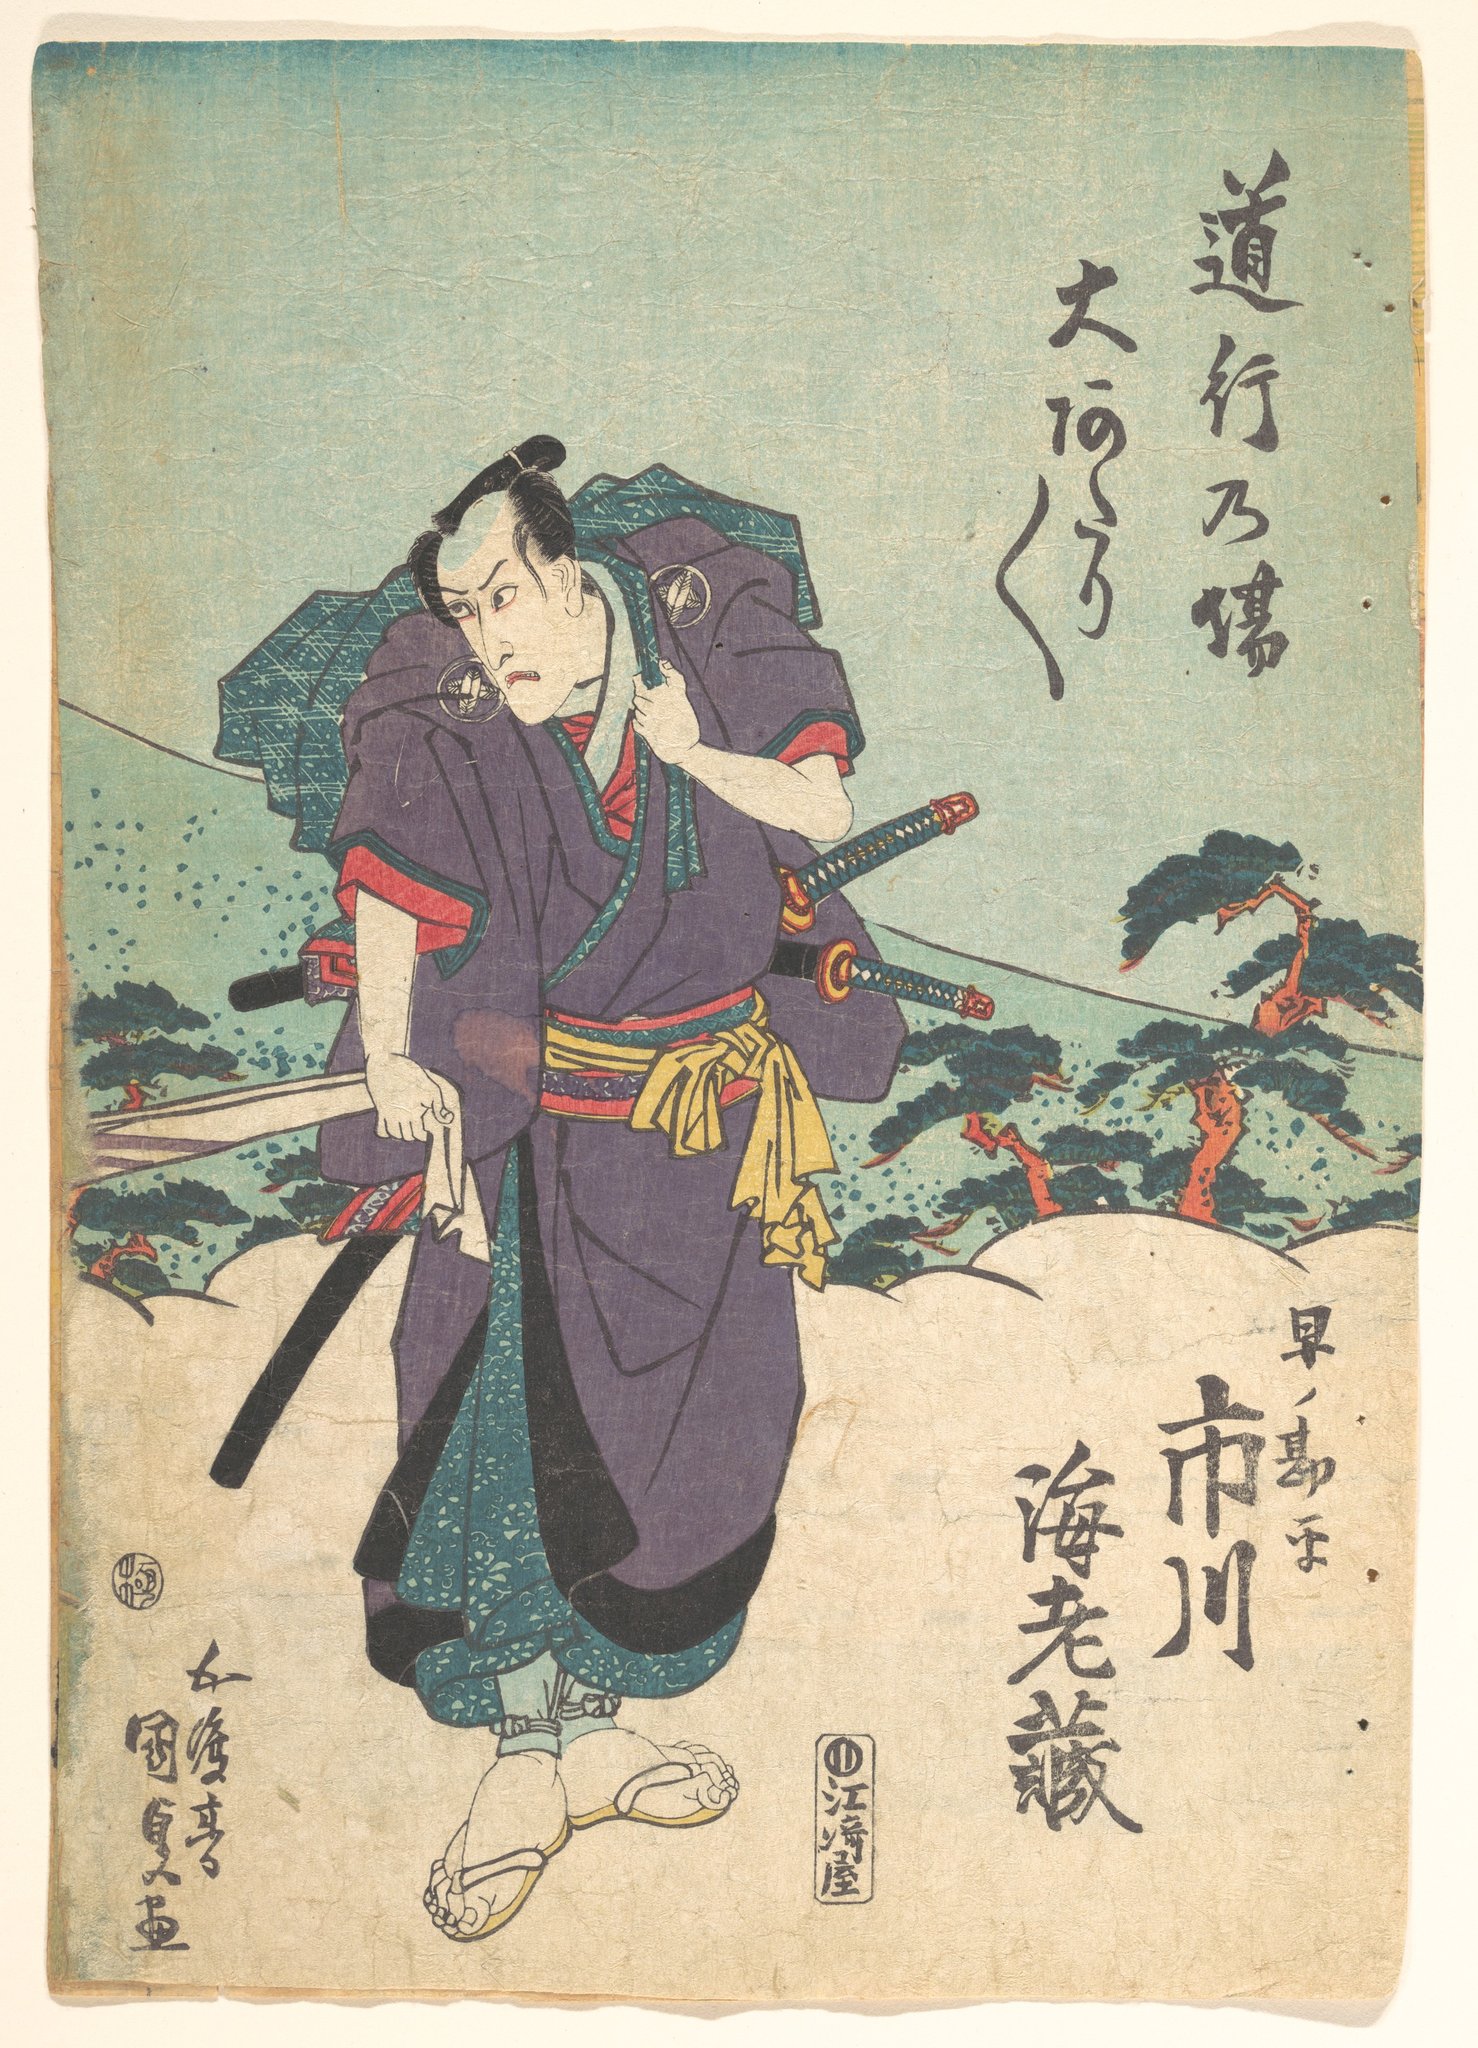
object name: print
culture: japanese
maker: utagawa kunisada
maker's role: artist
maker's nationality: japanese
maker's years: 1786-1864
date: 1801-1900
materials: ink, paper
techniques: woodblock print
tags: swords,men,trees